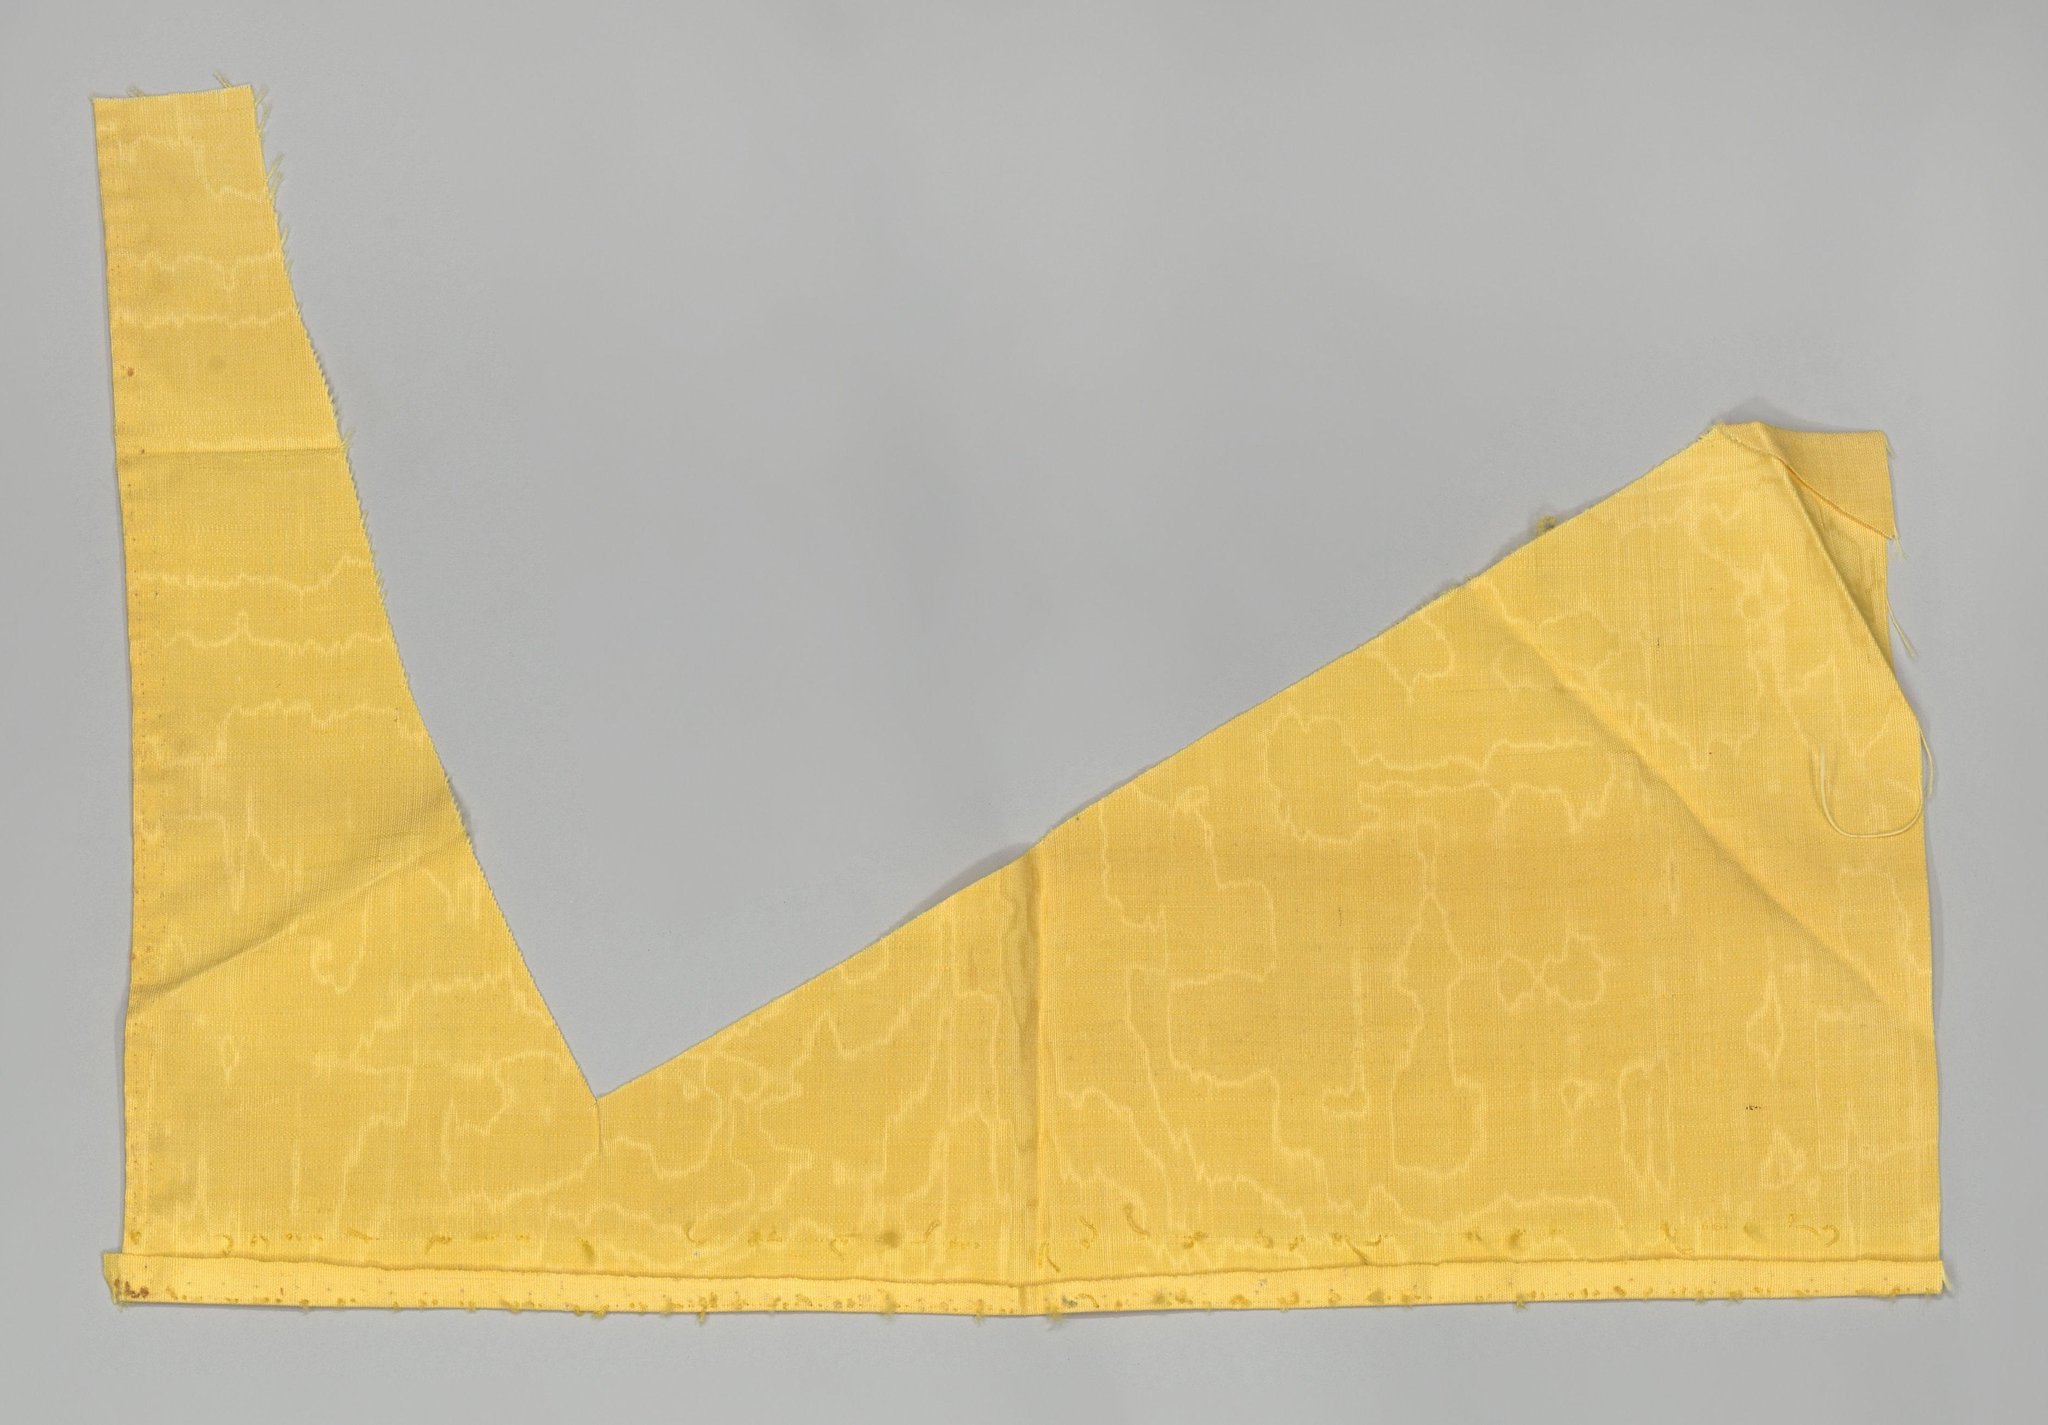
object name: fragment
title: Fragment van een bedgarnituur van gele gewaterde wol met groen passement en afhangende klosjes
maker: Anonymous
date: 1795-1815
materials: wool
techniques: moire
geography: northern netherlands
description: Fragment van een bedgarnituur van gele gewaterde wol, omboord met groen passement met een geel motief en met een groen en geel boordsel met afhangende klosjes die met gele en groene zijde zijn omwonden.